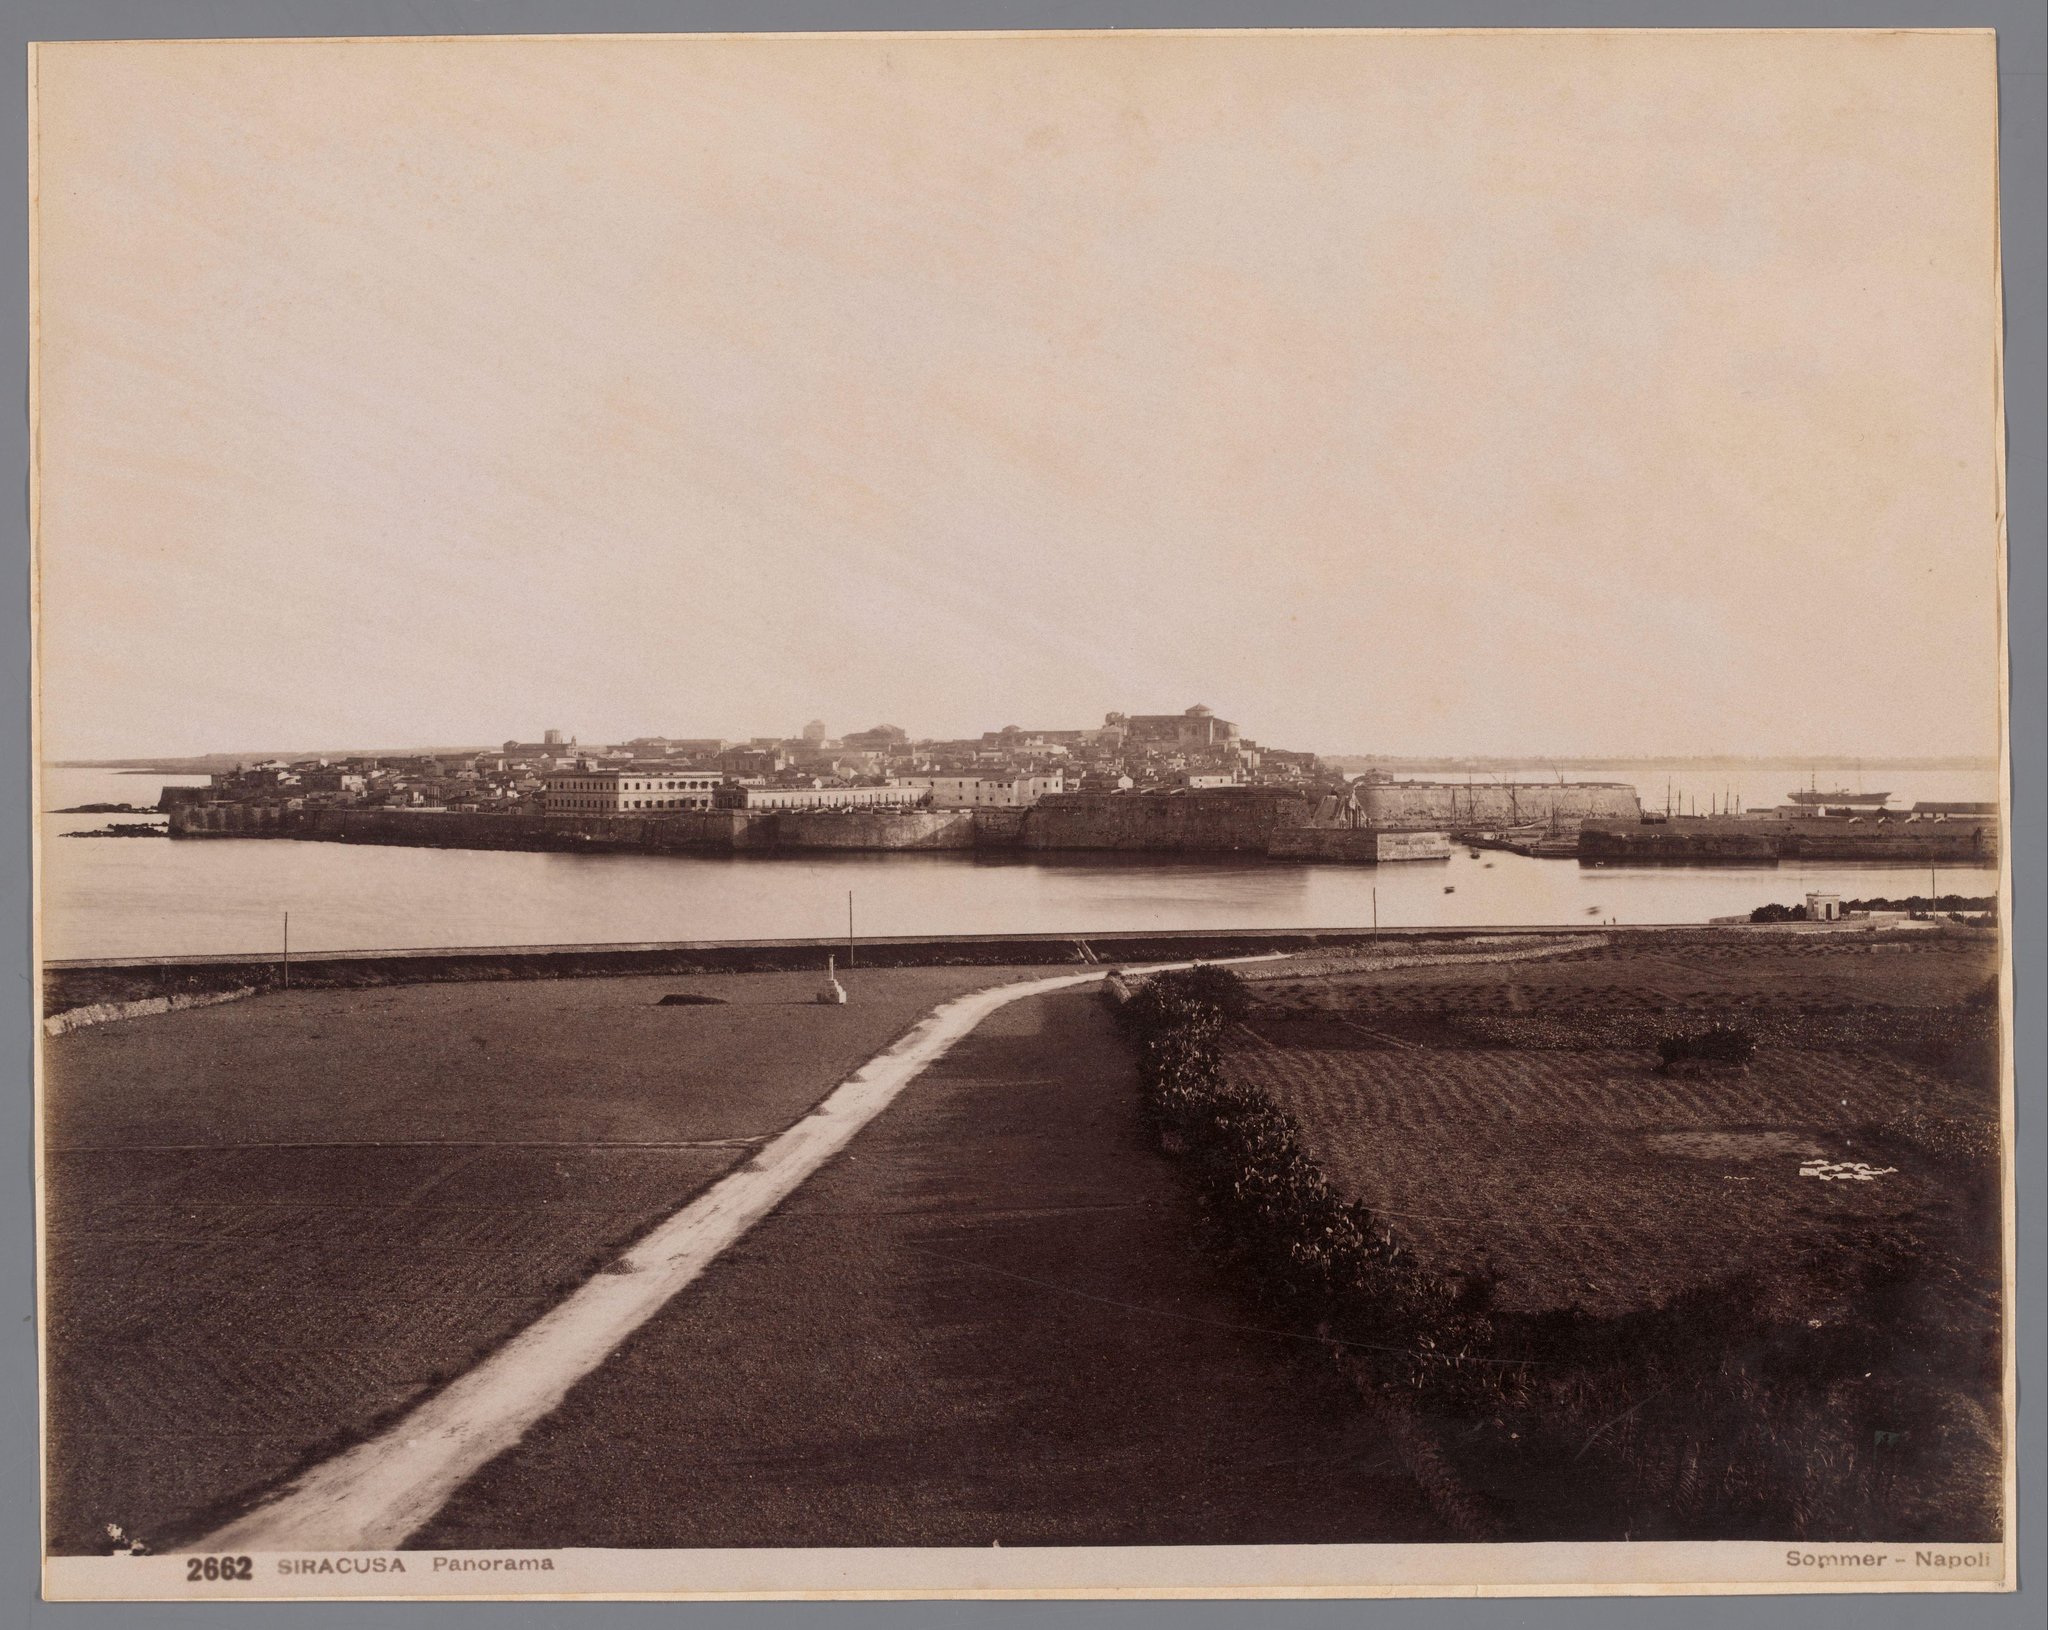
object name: photograph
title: Gezicht op Syracuse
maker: giorgio sommer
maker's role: fotograaf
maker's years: 1834-1914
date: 1857-1914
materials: cardboard, paper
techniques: albumen print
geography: syracuse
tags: island, prospect of city, town panorama, silhouette of city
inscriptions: number: ‘2662’